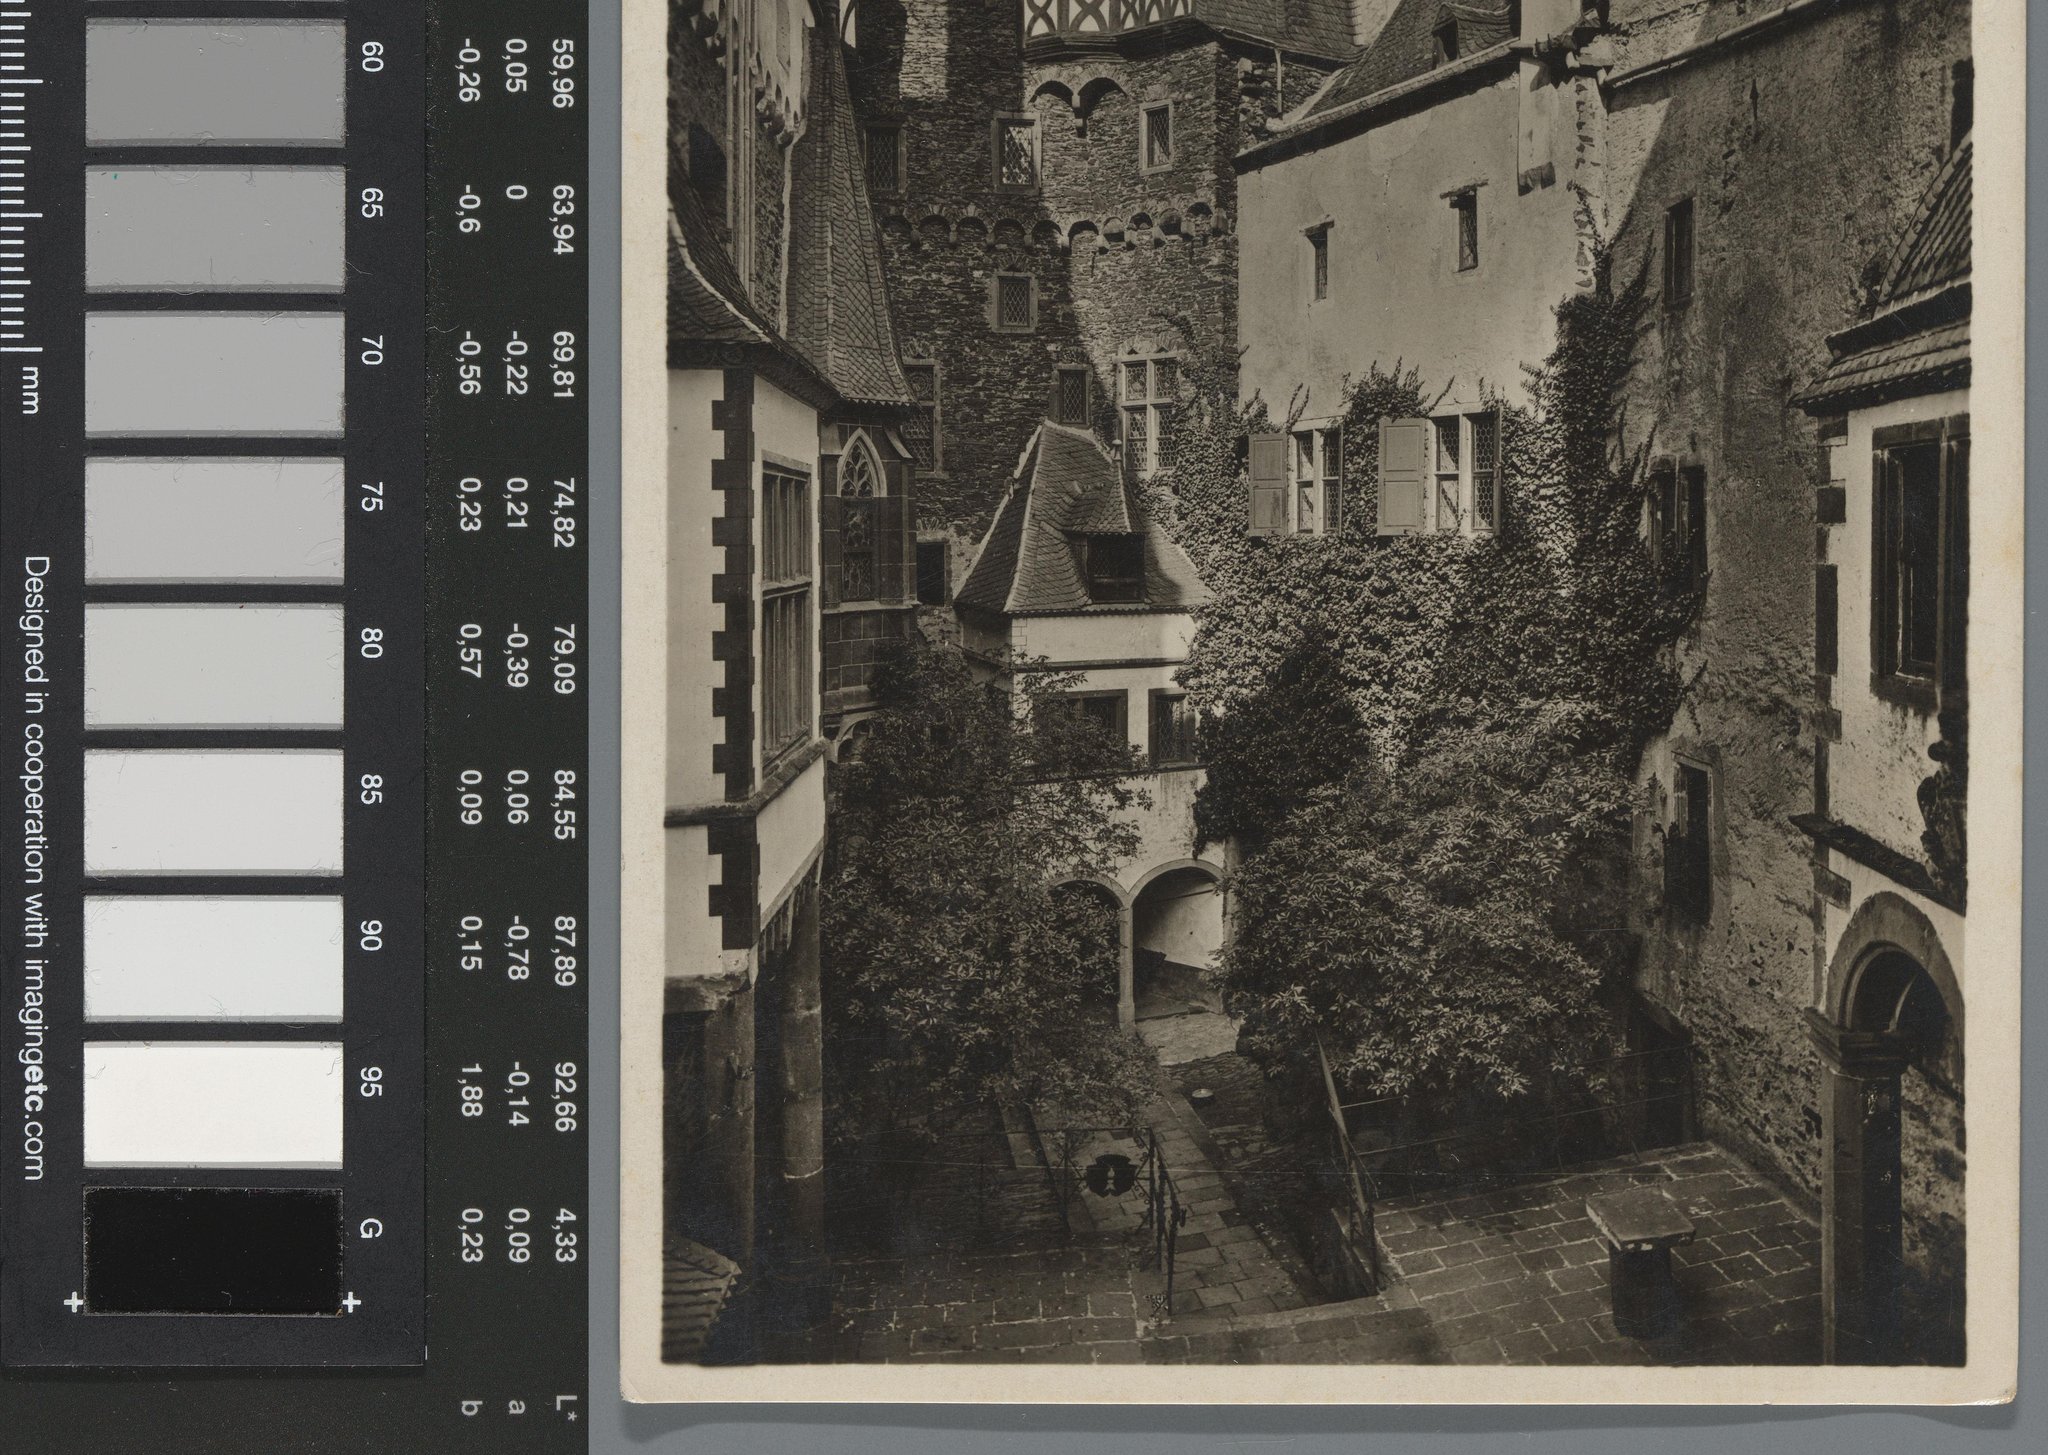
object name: postcard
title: Duitsland. Eltz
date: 1920-1950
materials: photographic support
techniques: gelatin silver print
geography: germany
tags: germany